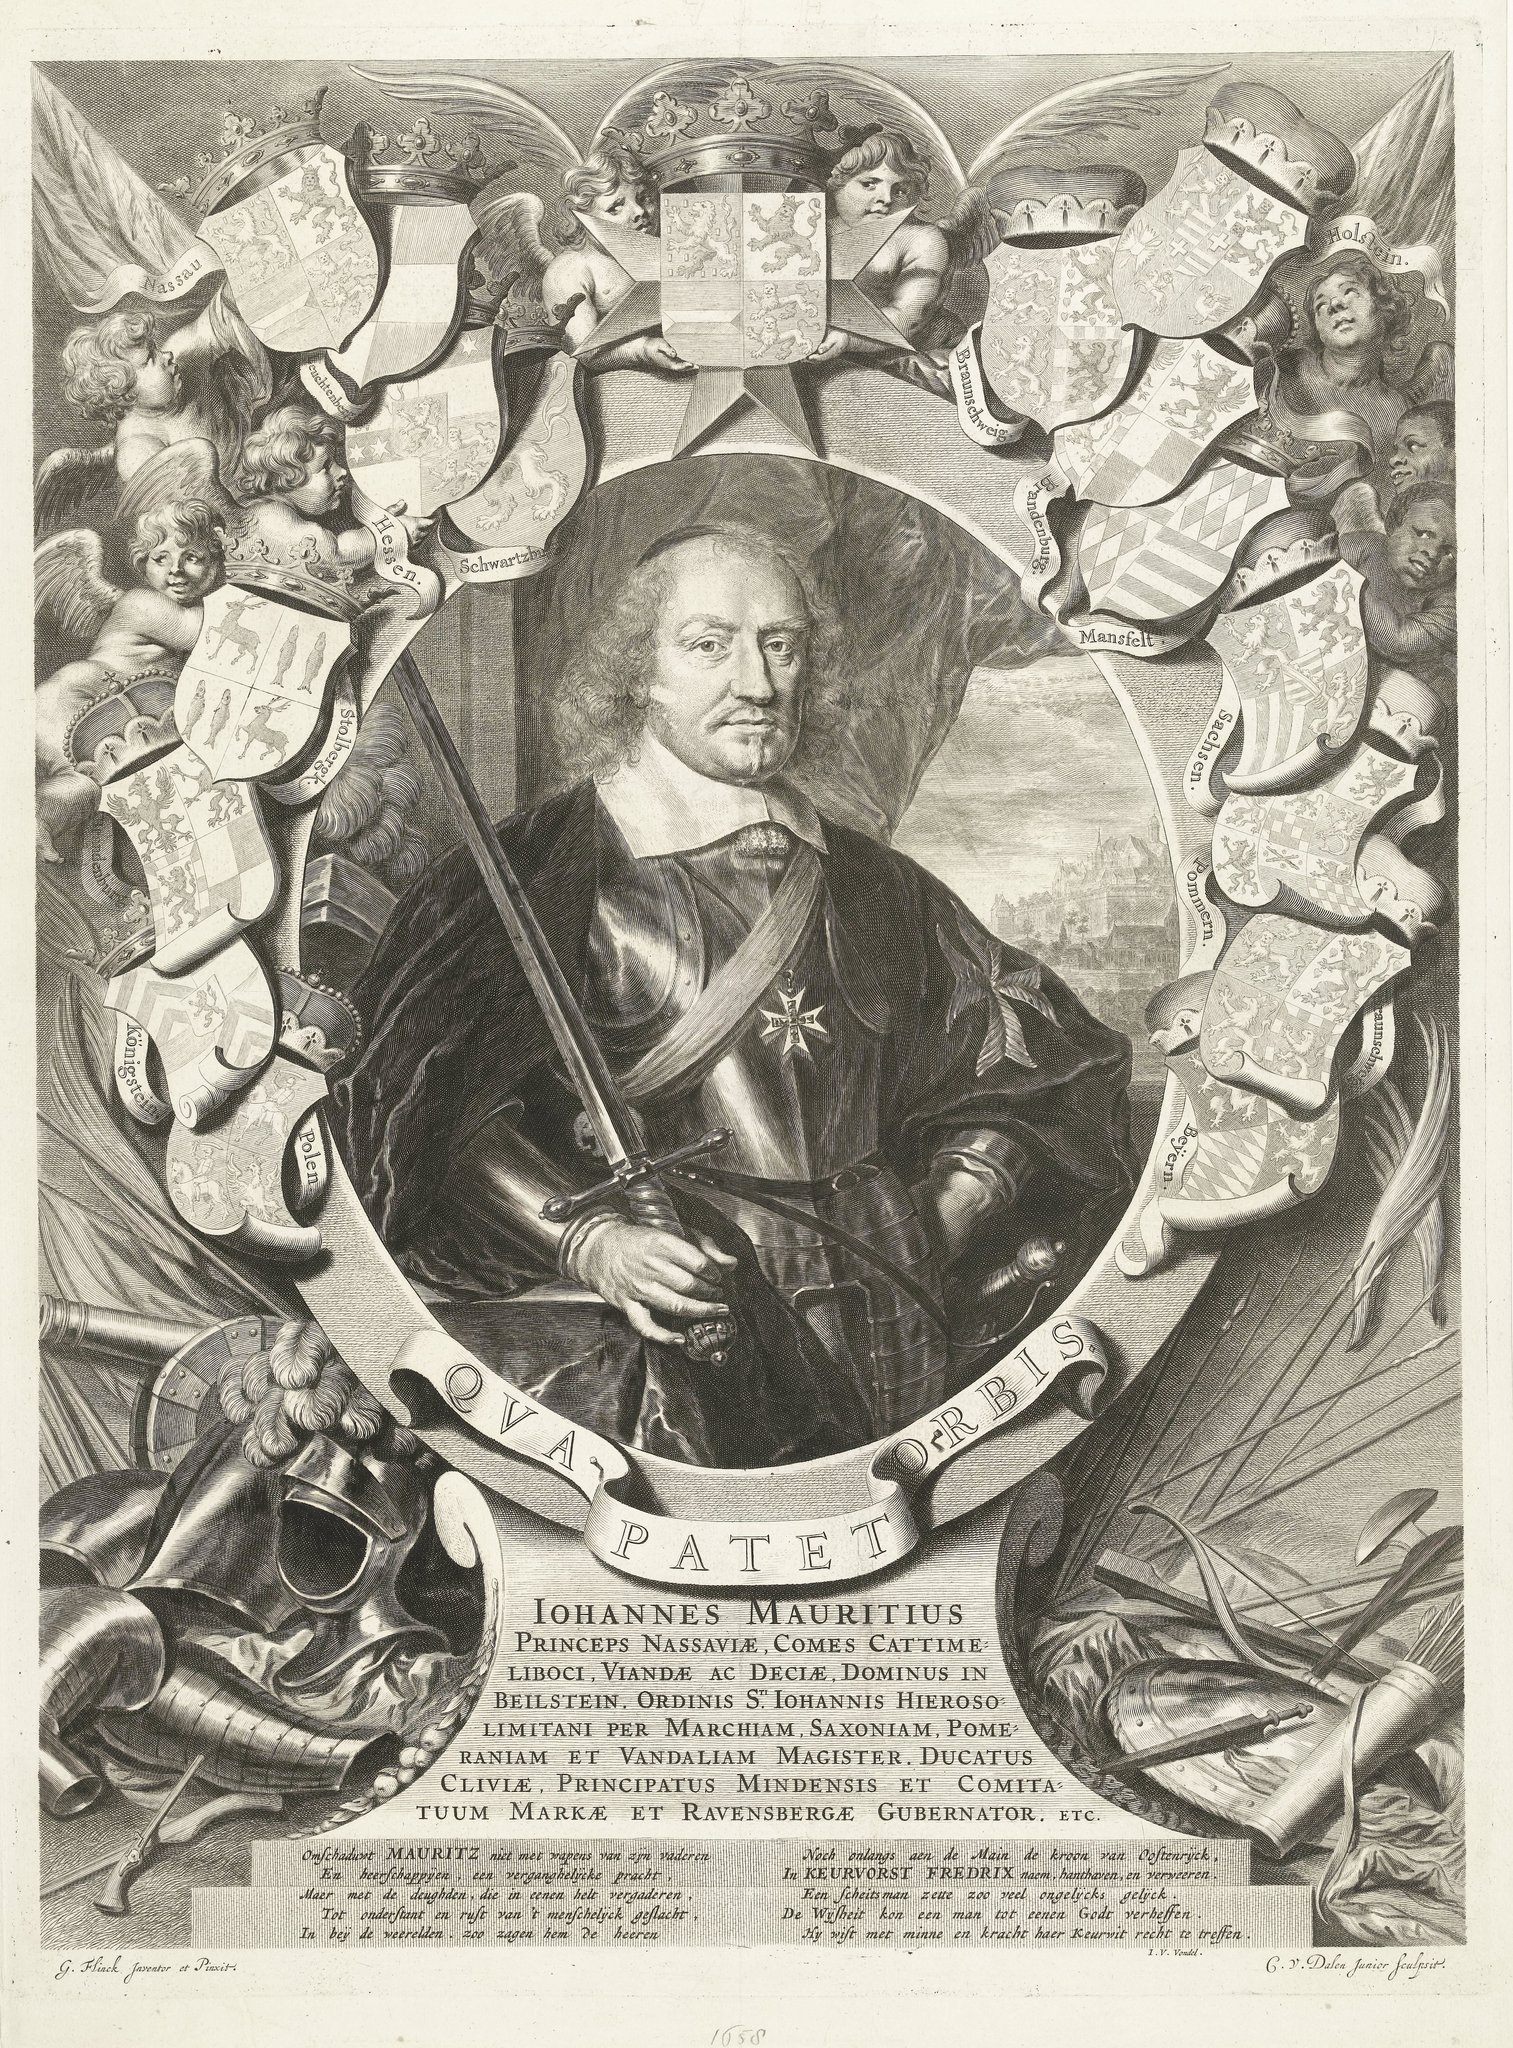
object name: print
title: Iohannes Mauritius Princeps (...) Markae et Ravensbergae Gubernator. etc.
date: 1658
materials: paper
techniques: engraving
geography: amsterdam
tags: earl, johan maurits graaf van nassau-siegen, cleves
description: Portret van Johan-Maurits, vorst van Nassau-Siegen en gouverneur-generaal van Nederlands-Brazilië, ten halven lijve in ovale omlijsting met gekroonde wapenschilden welke worden gedragen door kleine engelen. Twee engelen rechts hebben een donkere huidskleur, zij verwijzen naar de jarenlange aanwezigheid van de, toen nog graaf, in Brazilië. Achter de vorst een gezicht op Kleve. Op lint motto: Qva patet orbis. Op voet Nederlands vers in tien regels van Joost van den Vondel.